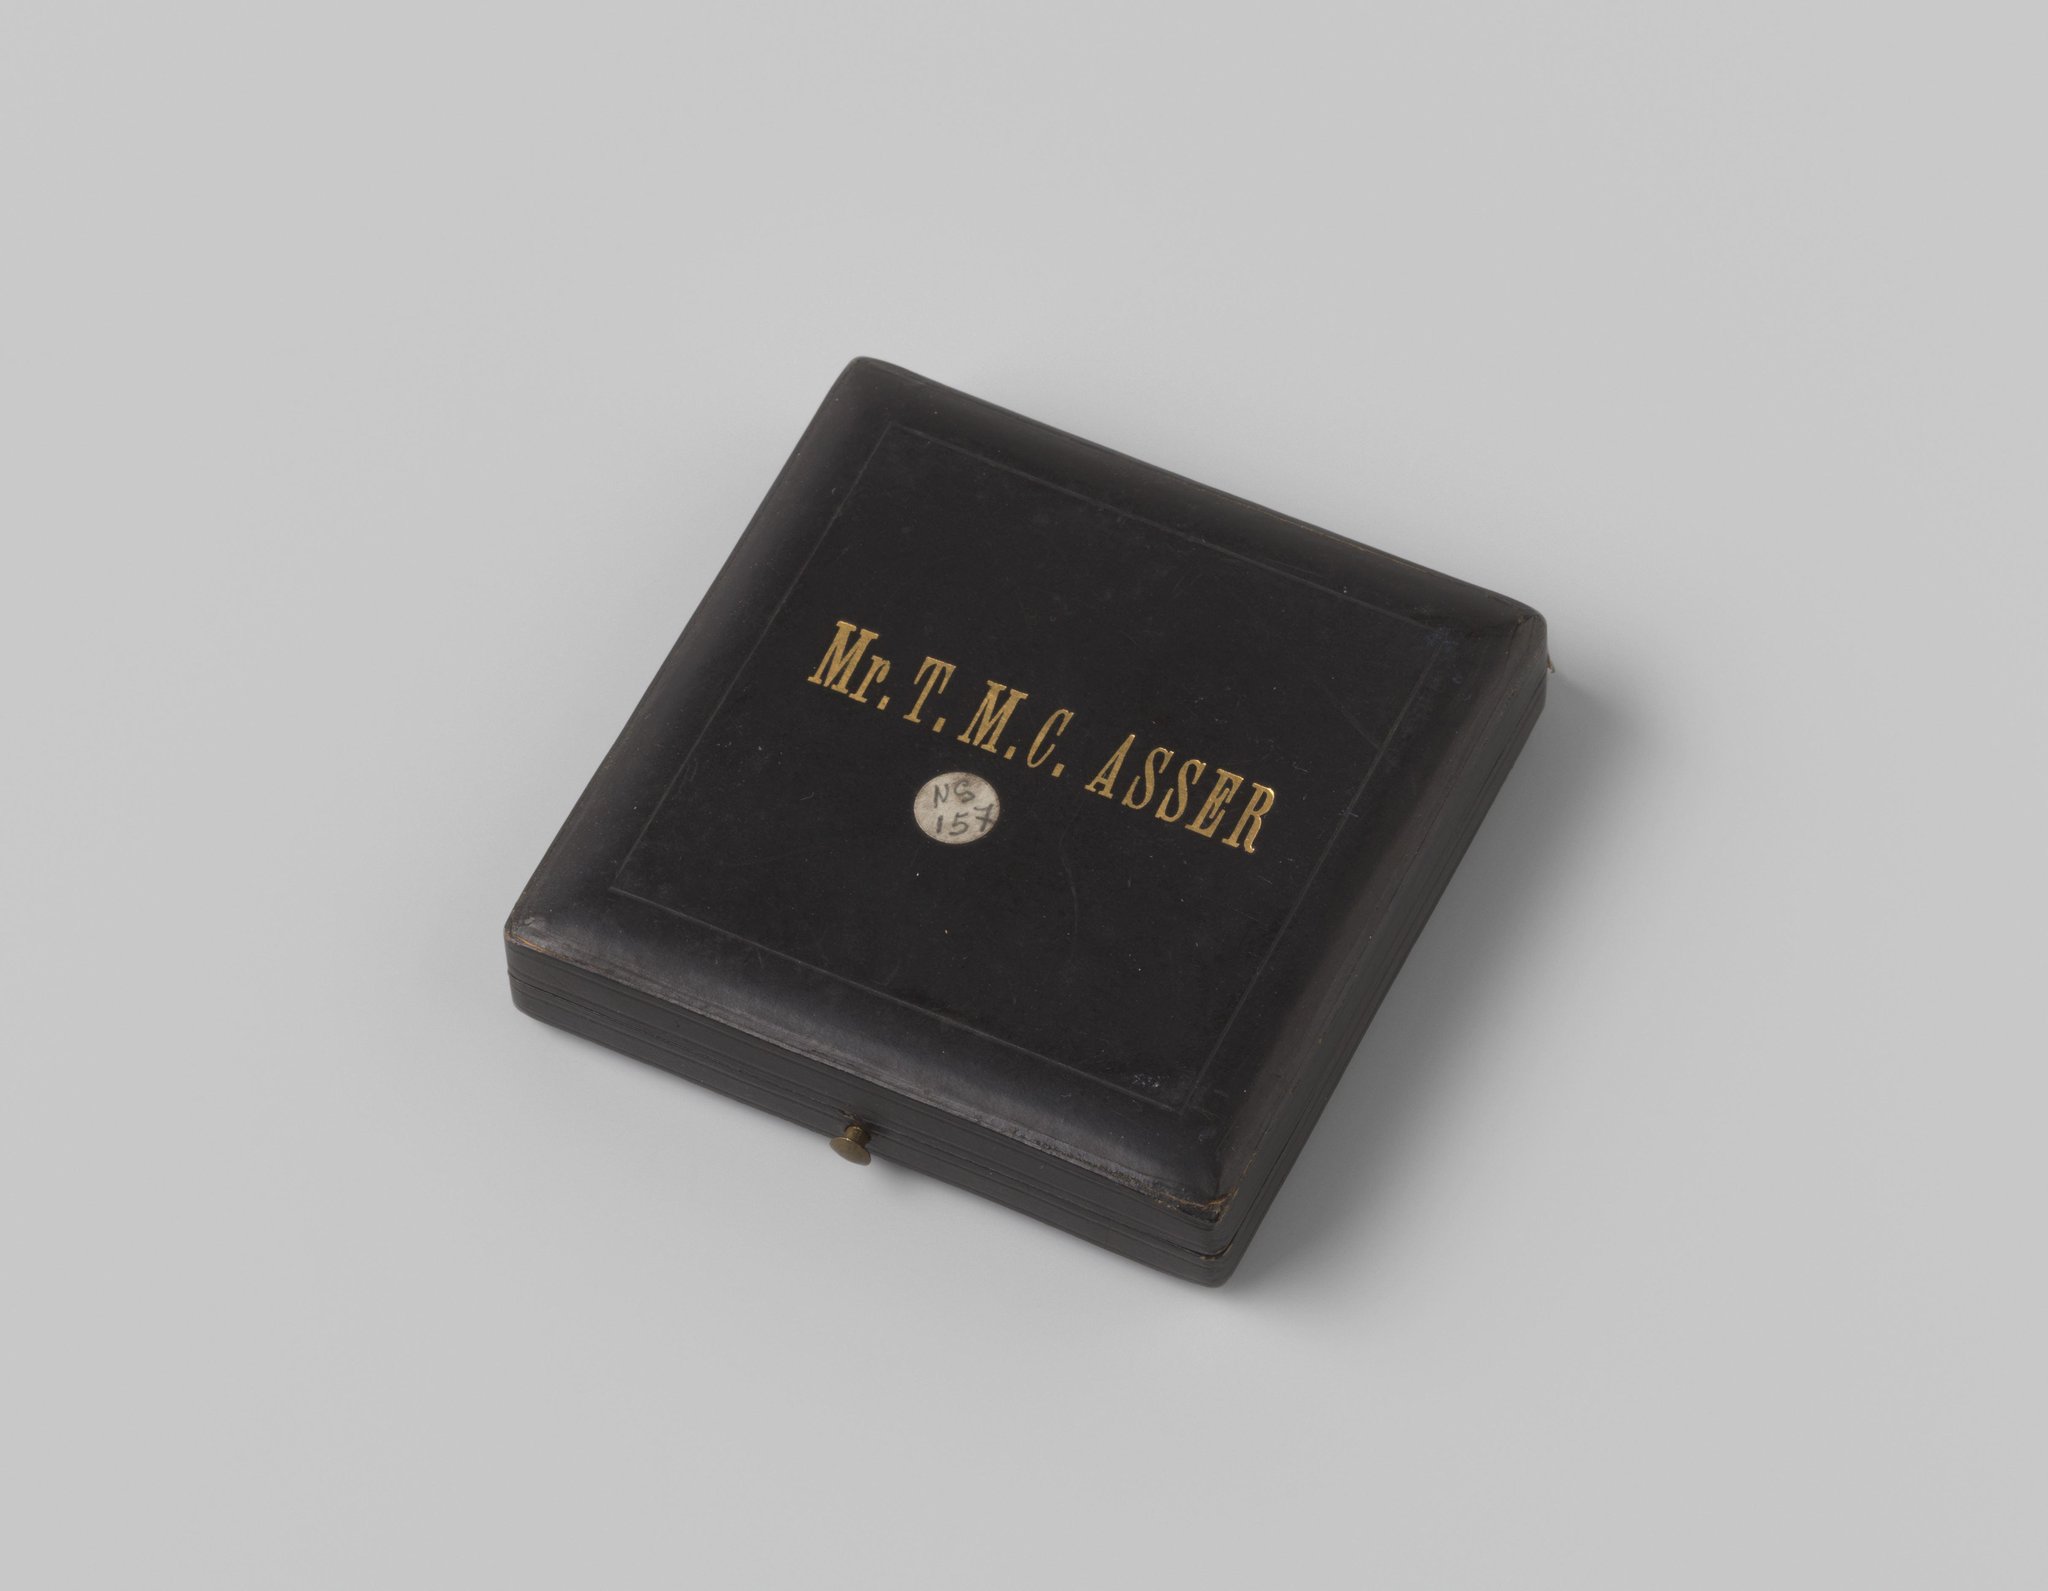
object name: box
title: Doos horende bij een historiepenning op Mr. T.M.C. Asser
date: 1893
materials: copper, leather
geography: utrecht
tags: amsterdam, the hague, utrecht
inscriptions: date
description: Zwart vierkant doosje waarop staat: Mr. T.M.C. Asser.